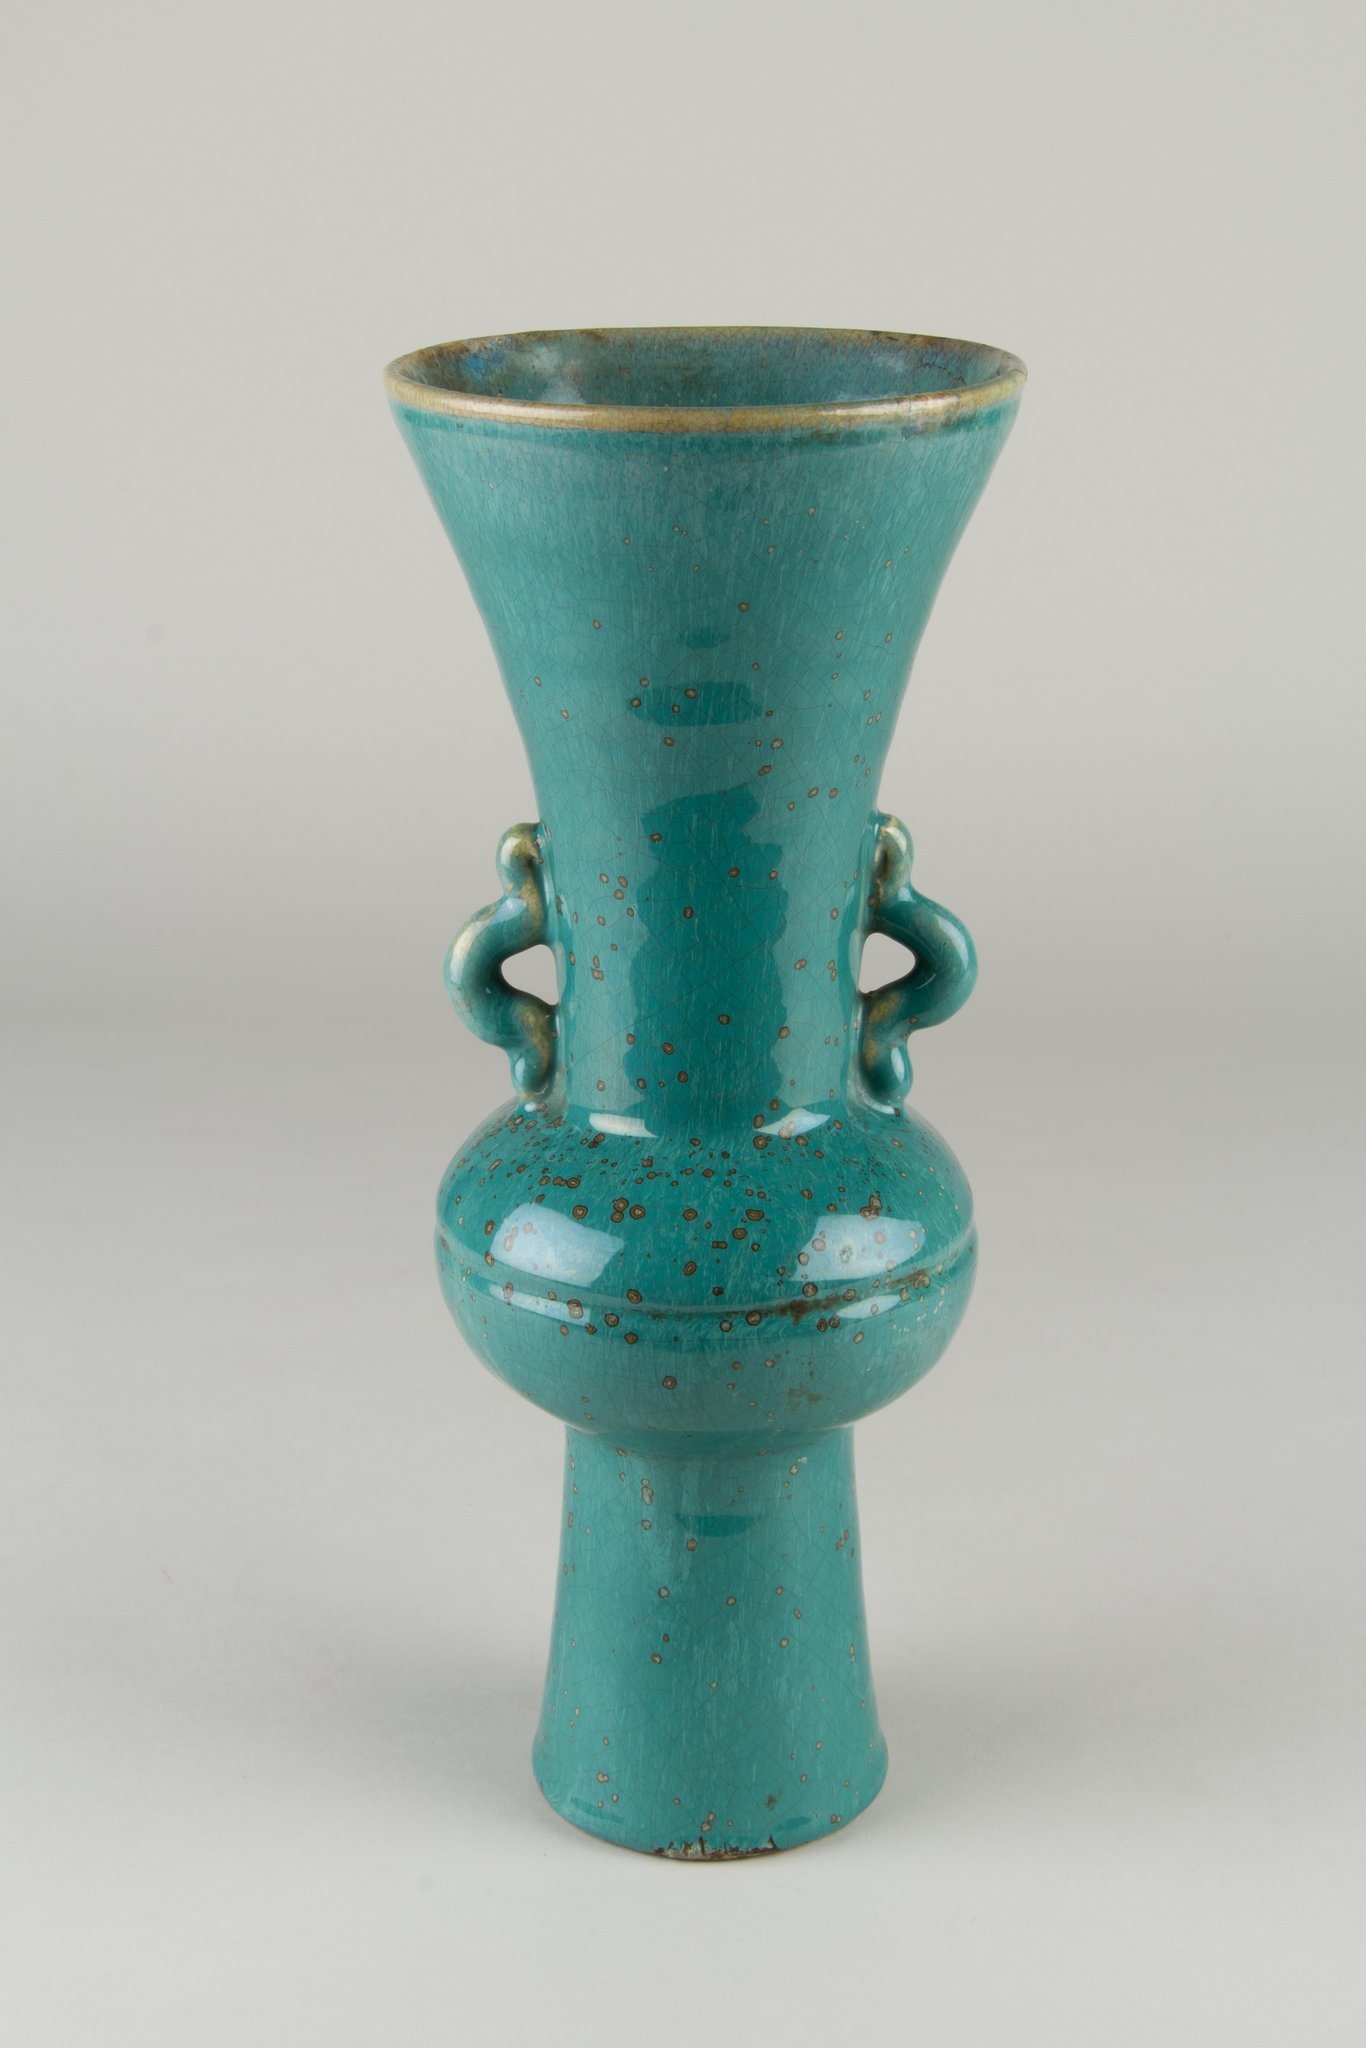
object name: vase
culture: japanese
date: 1834-1866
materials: glaze, stoneware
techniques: overglaze